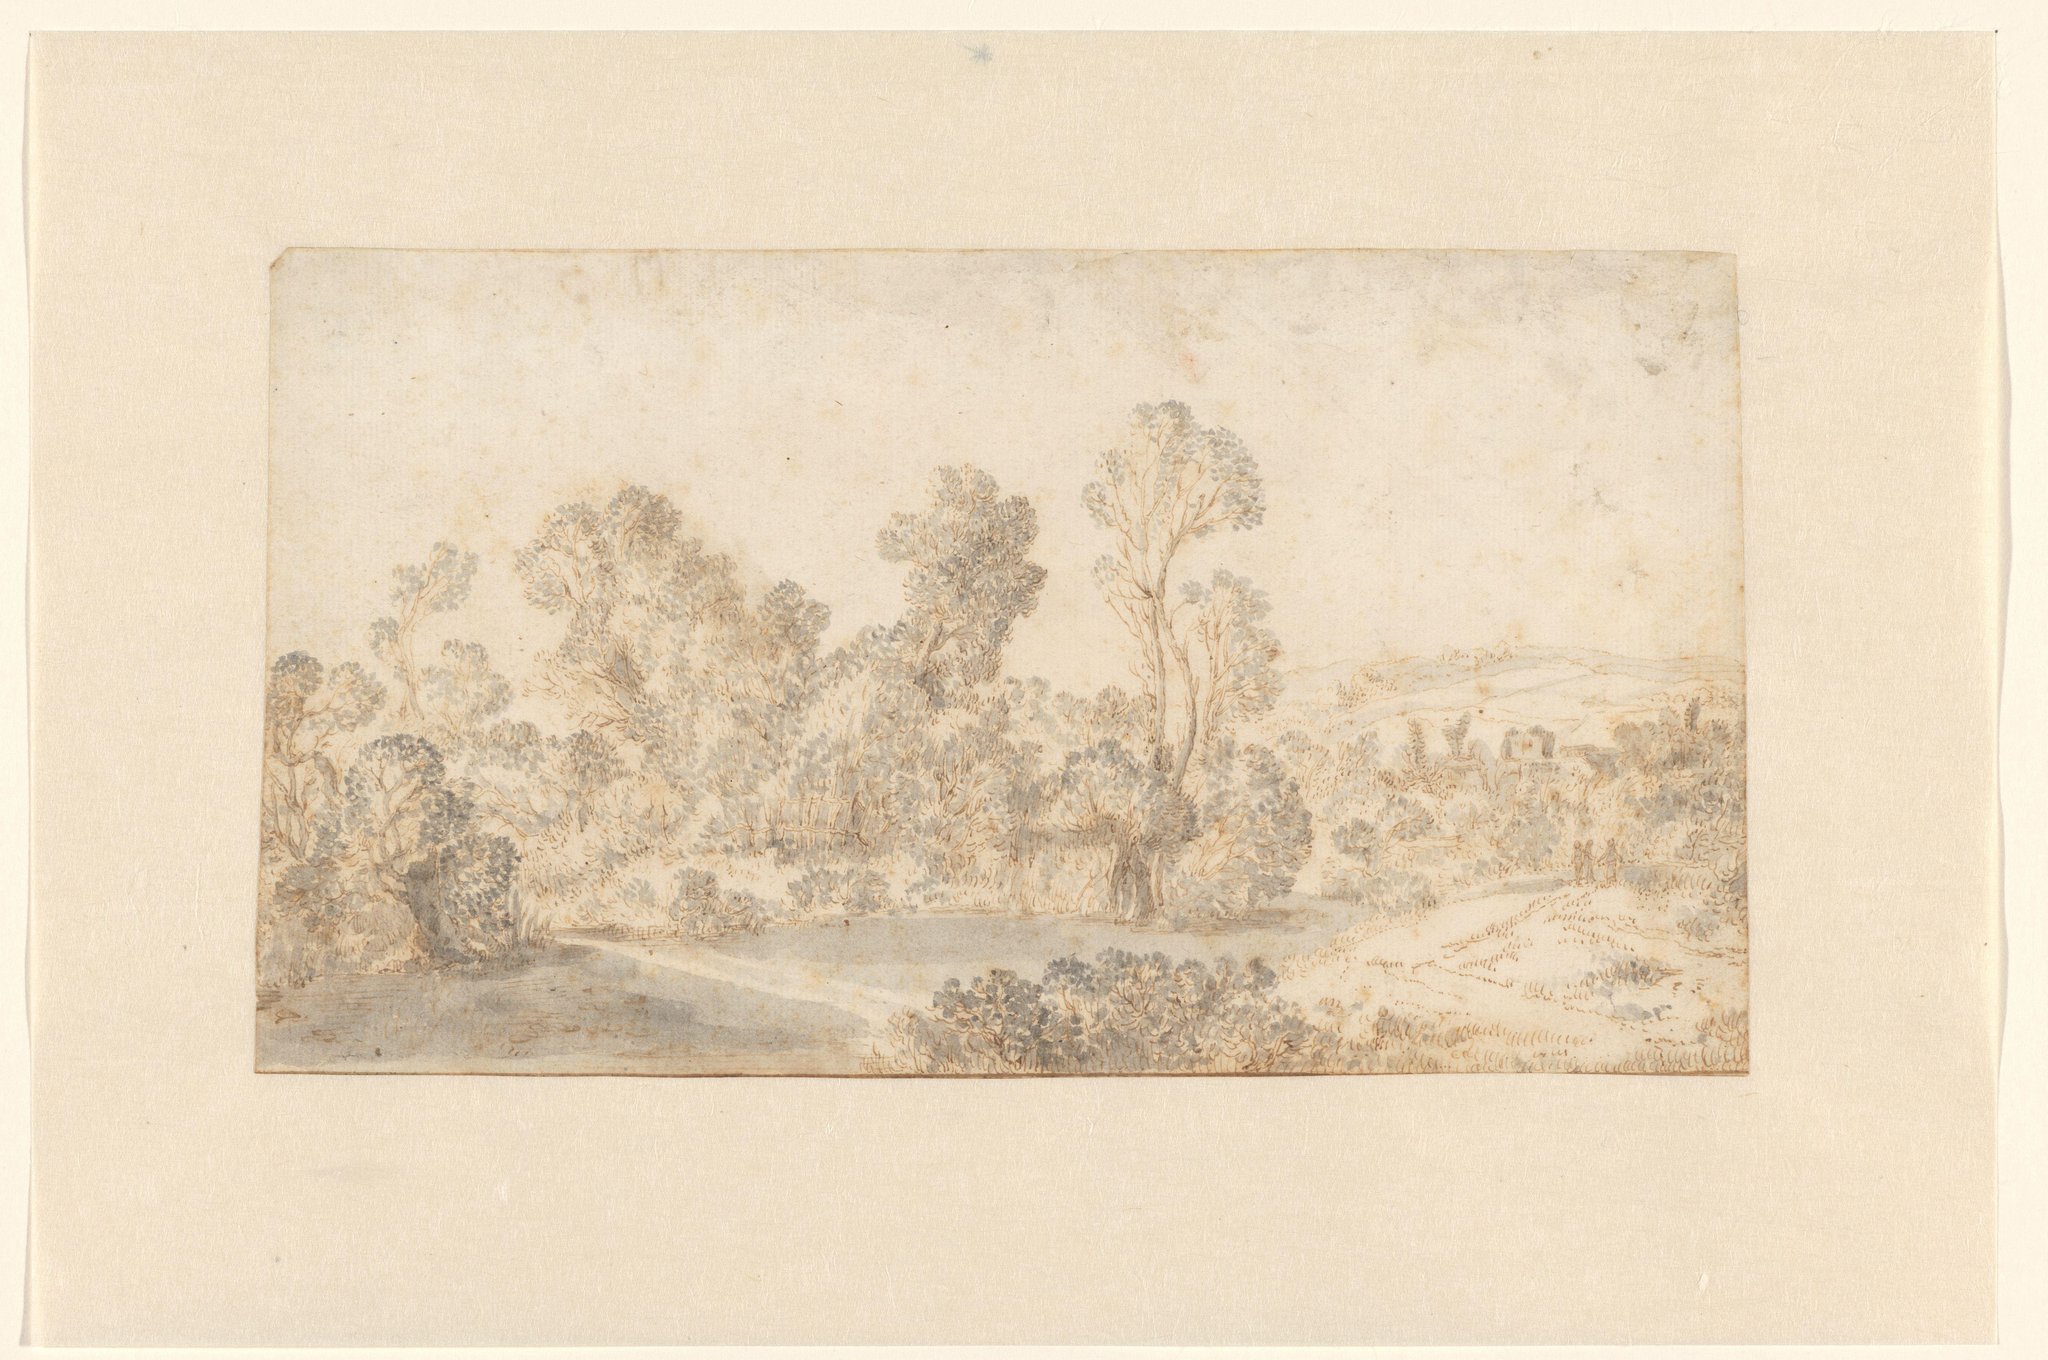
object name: drawing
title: Heuvelachtig landschap met hoge bomen langs een rivier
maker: gillis claesz de hondecoeter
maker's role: draughtsman, painter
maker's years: 1575-1638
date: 1585-1638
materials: ink, paper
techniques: brush, pen